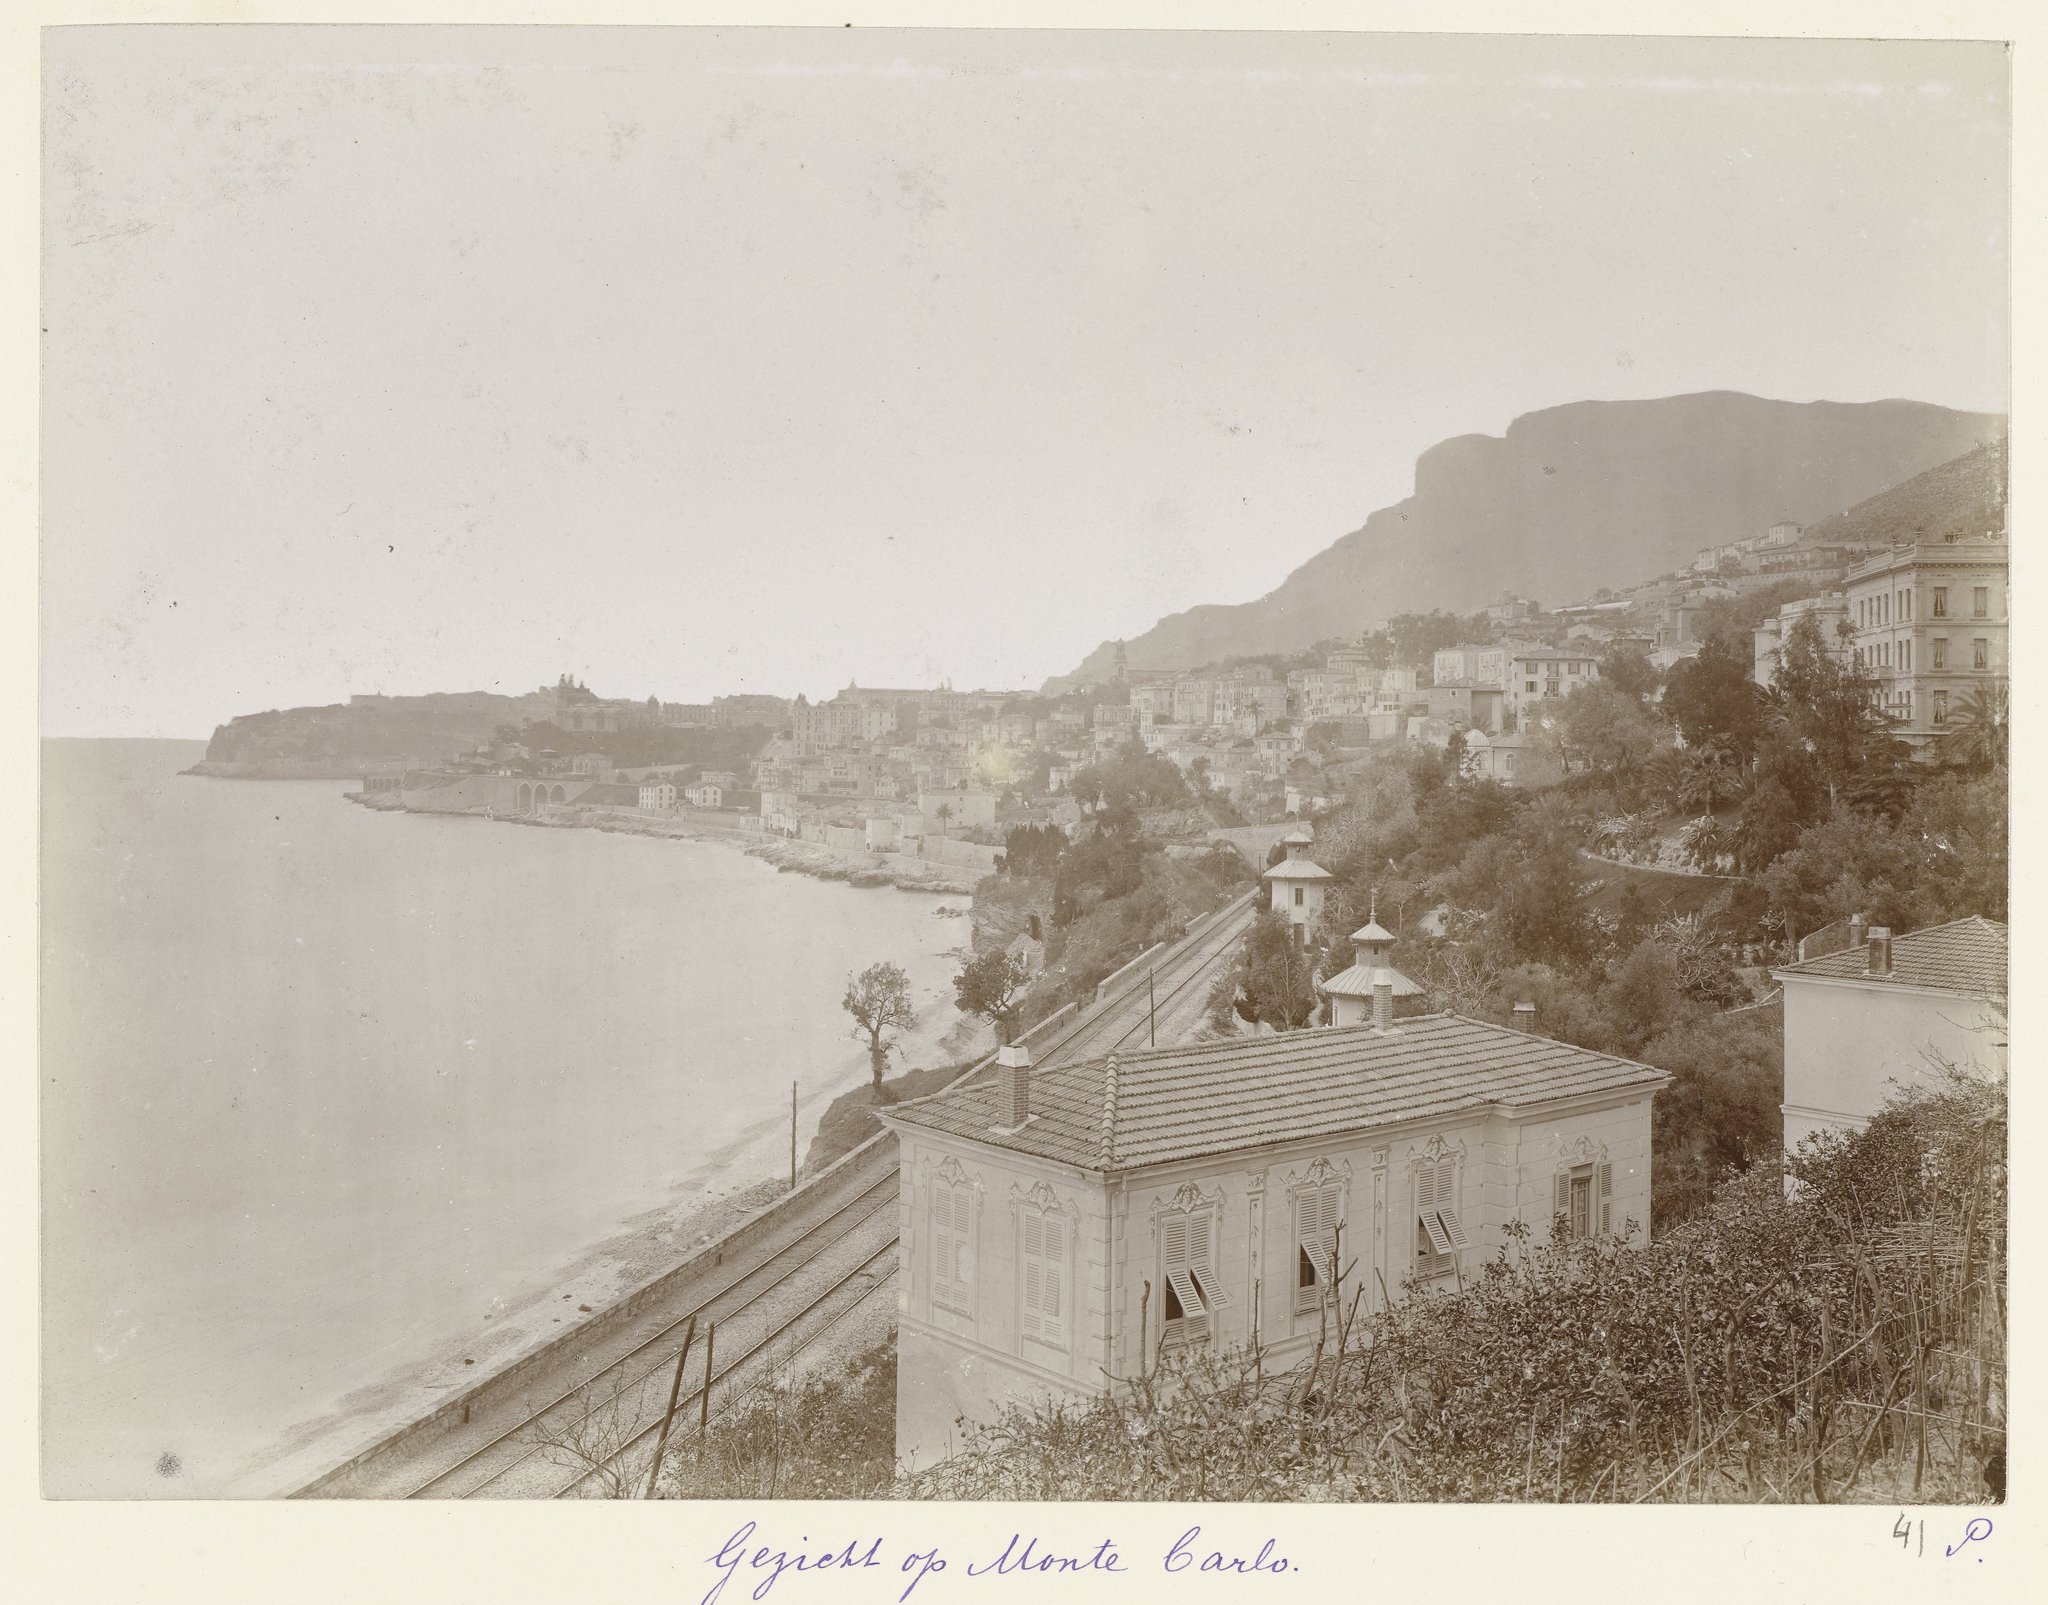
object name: photograph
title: Gezicht op Monte Carlo.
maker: henry pauw van wieldrecht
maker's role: fotograaf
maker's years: 1863-1912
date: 1886-1896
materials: cardboard, photographic support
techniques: albumen print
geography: monaco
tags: monte carlo